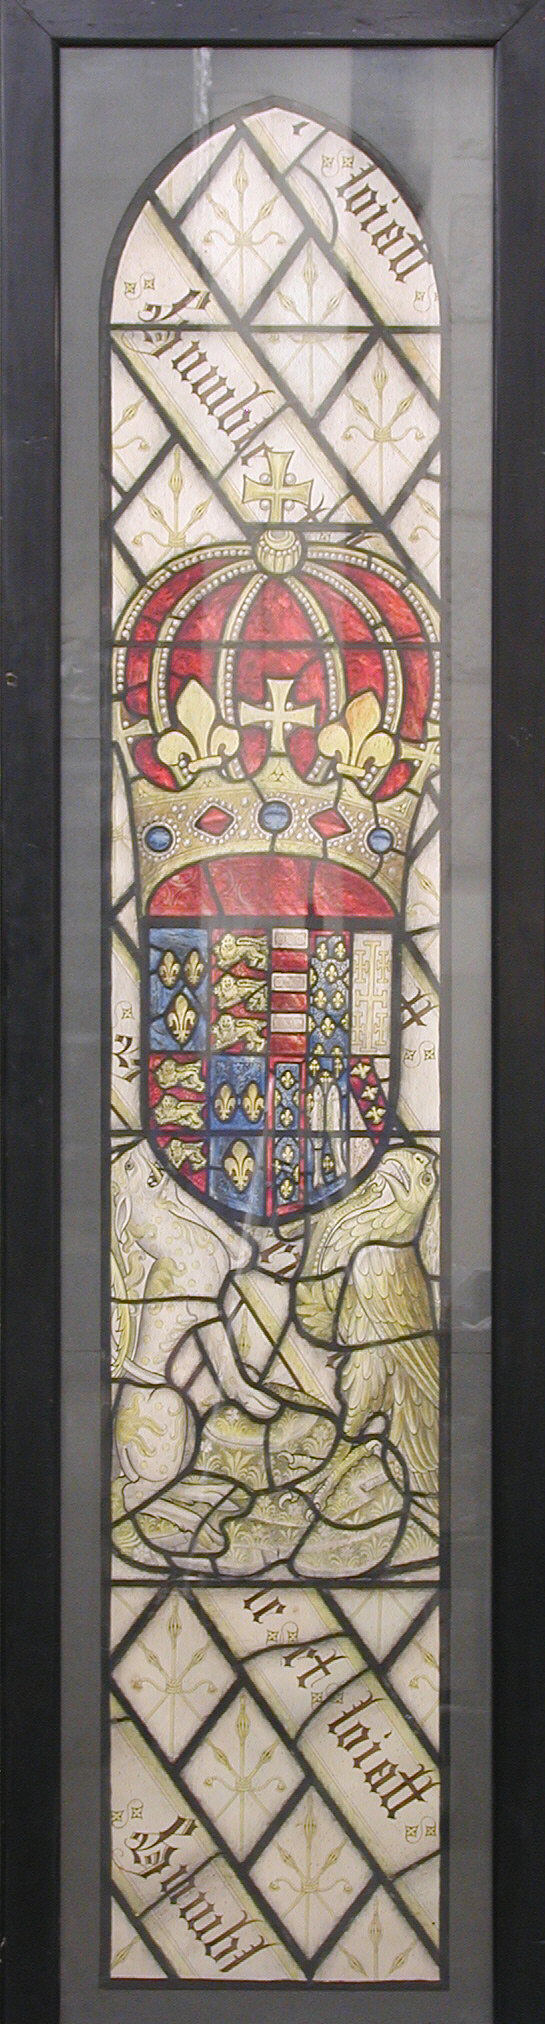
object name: panel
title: Panel with Coat of Arms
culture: british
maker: alfred a. bradbury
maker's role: artist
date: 1901-1933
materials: paper, pencil, watercolor